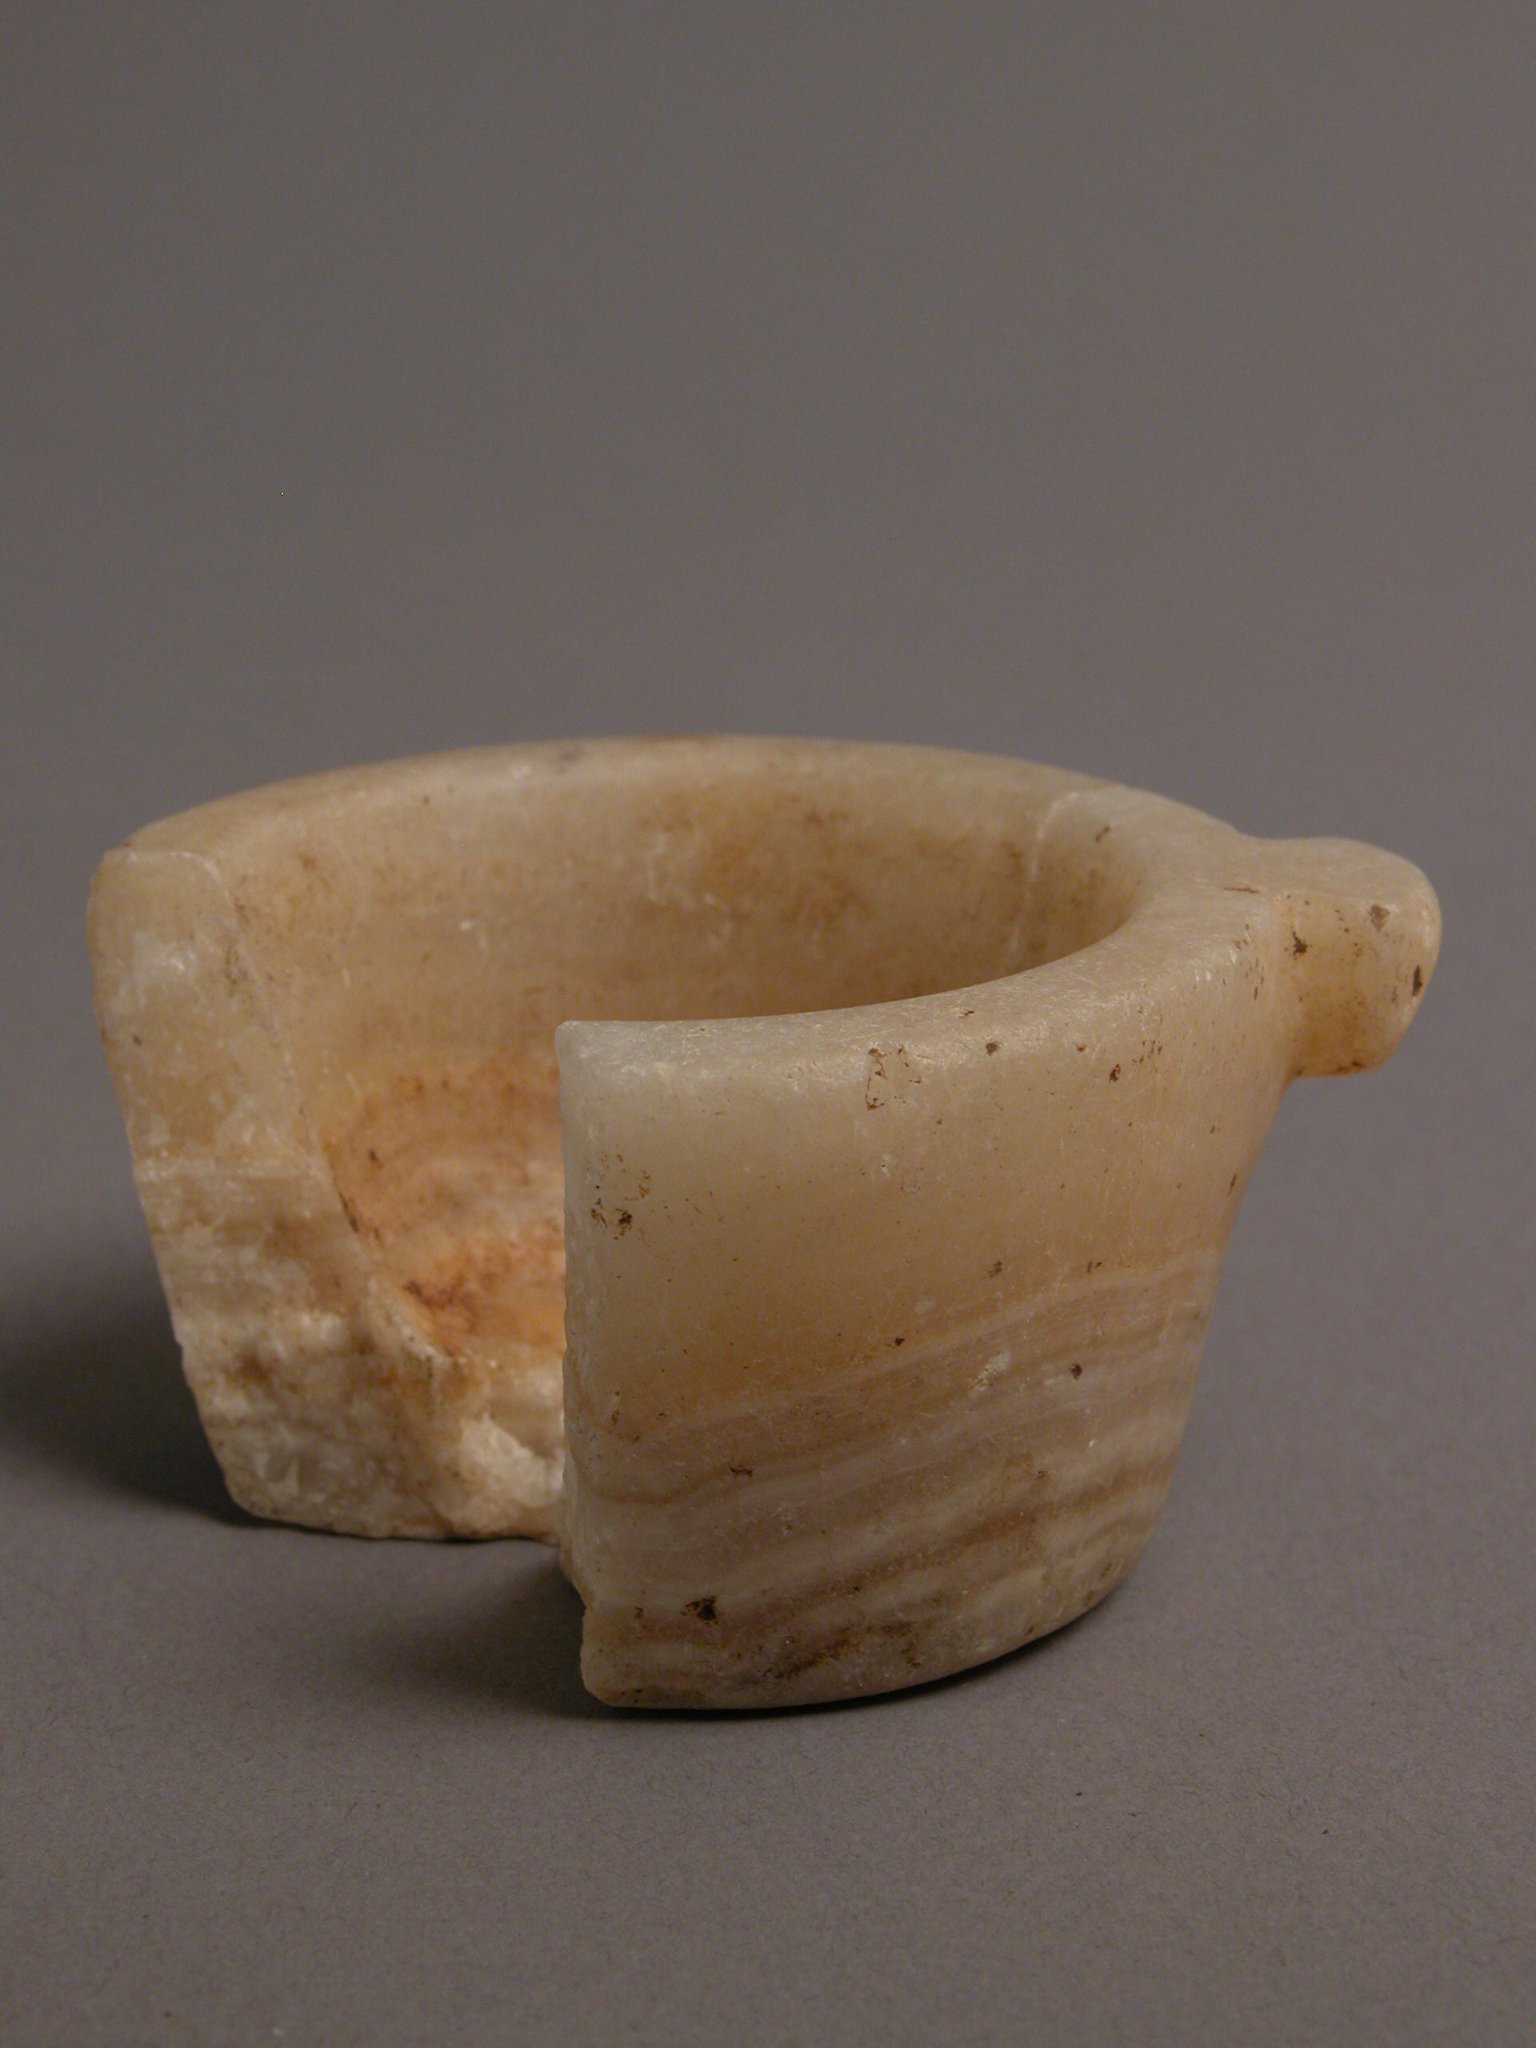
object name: vessel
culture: coptic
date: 301-700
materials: alabaster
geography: egypt